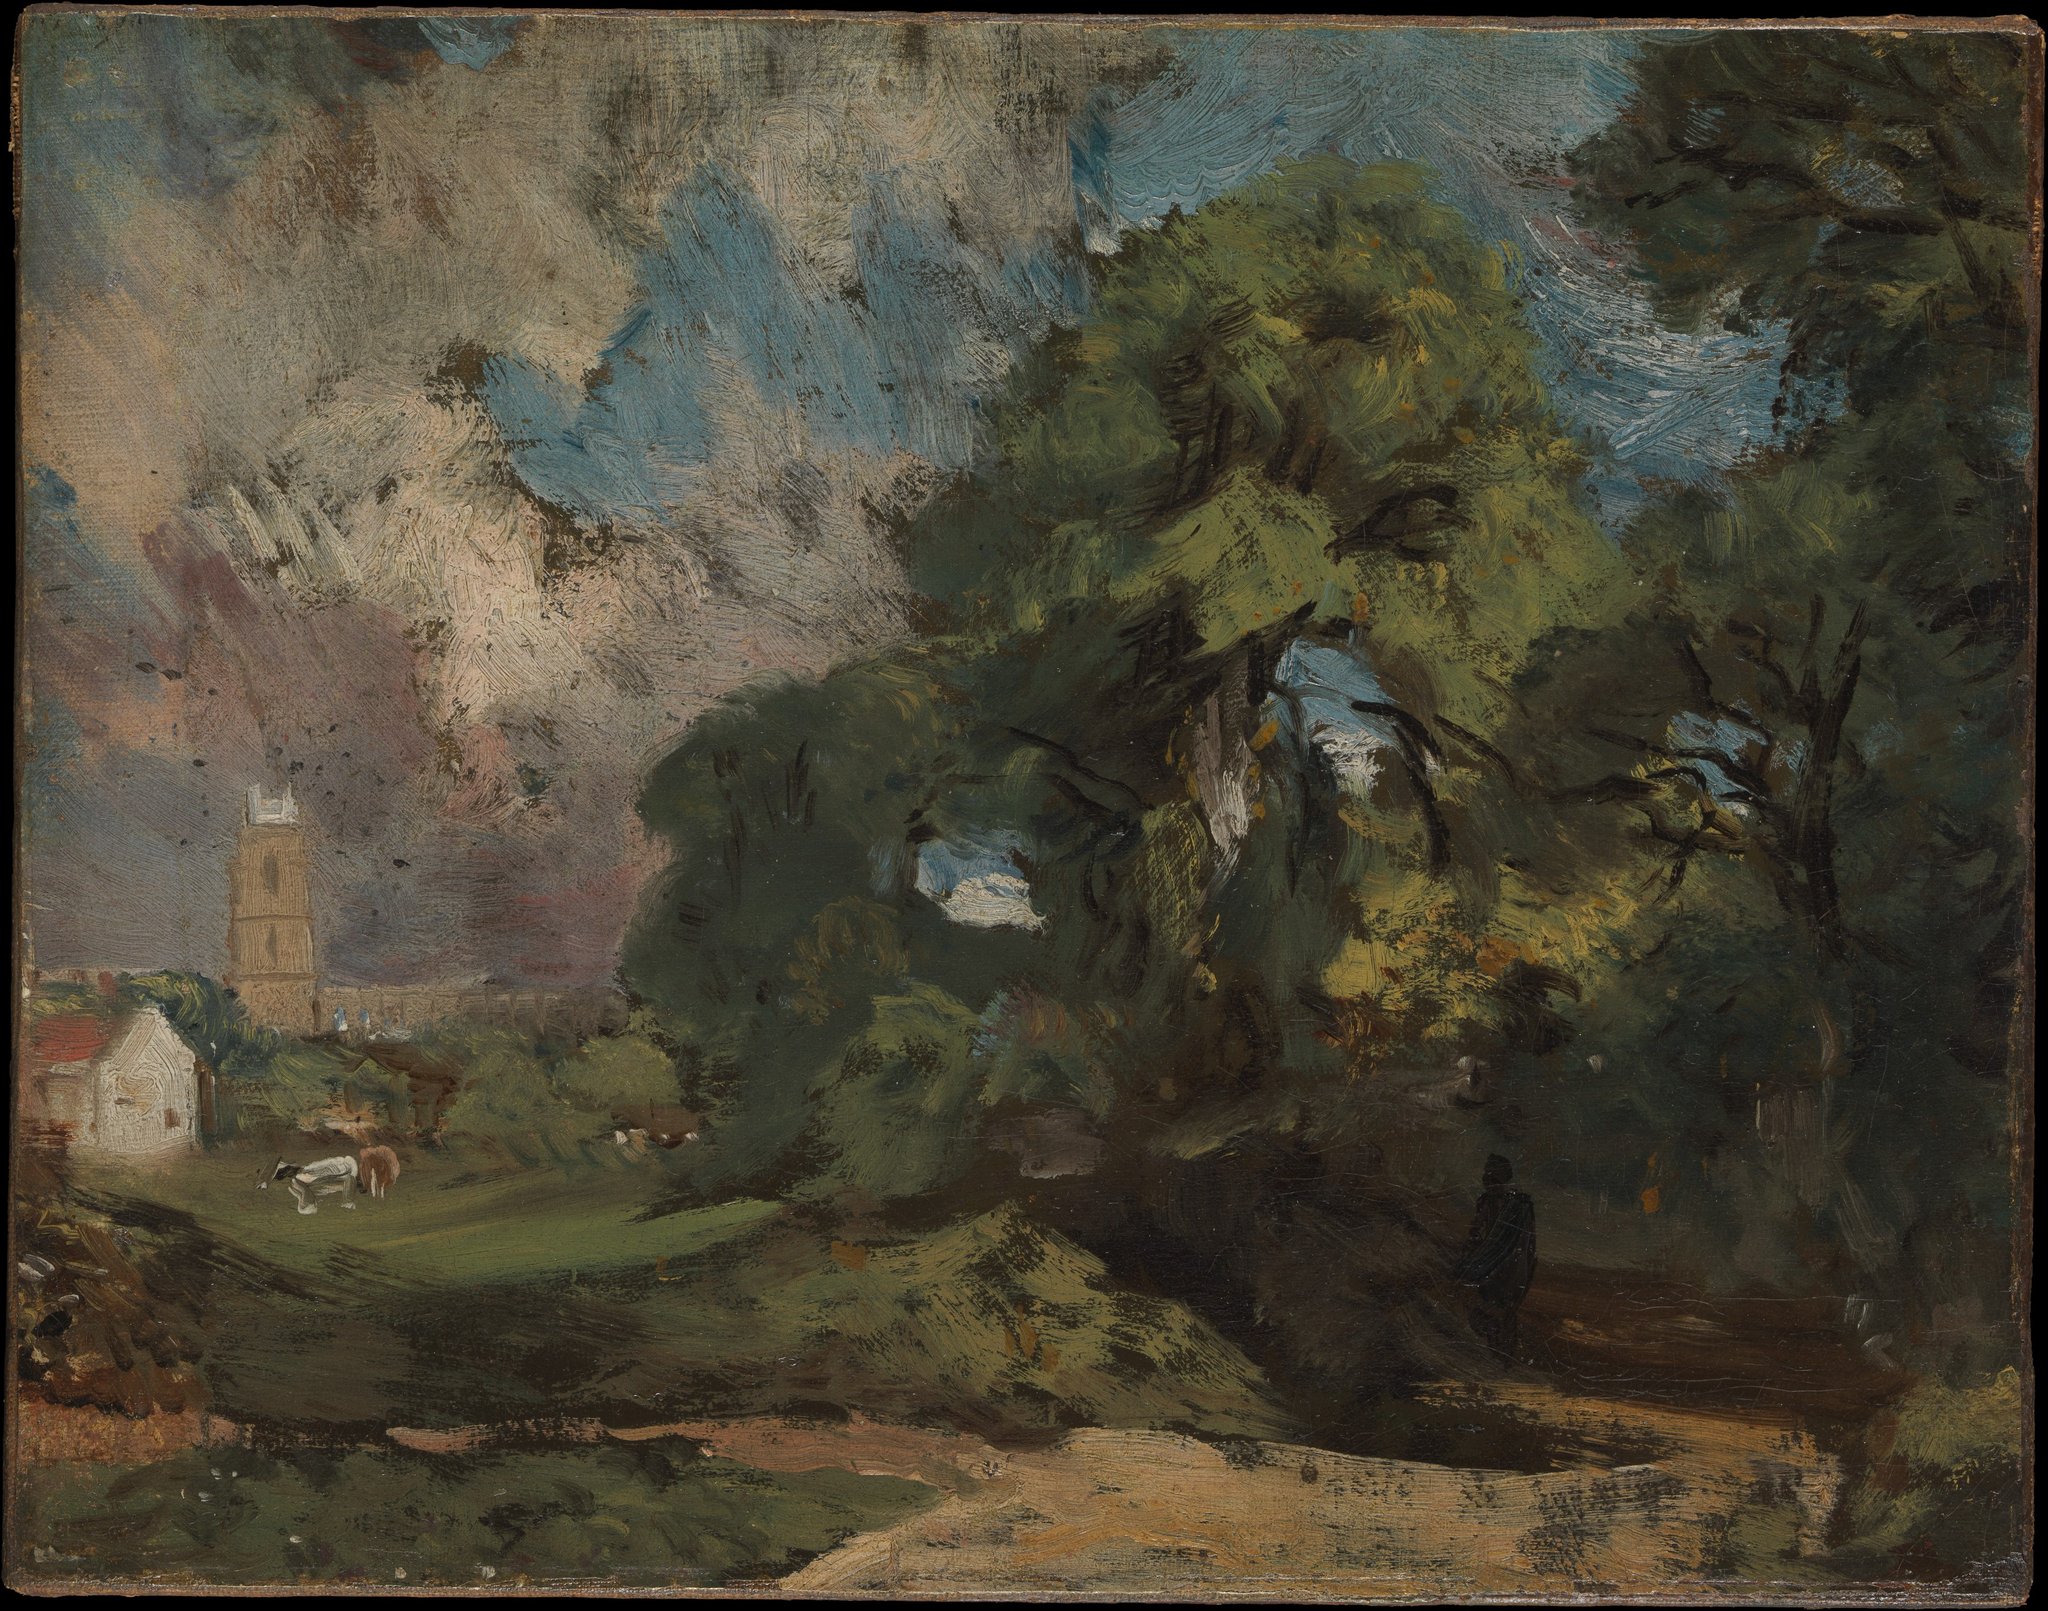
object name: painting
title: Stoke-by-Nayland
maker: john constable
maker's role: artist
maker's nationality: british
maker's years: 1776-1837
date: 1810-1811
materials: canvas, oil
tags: landscapes